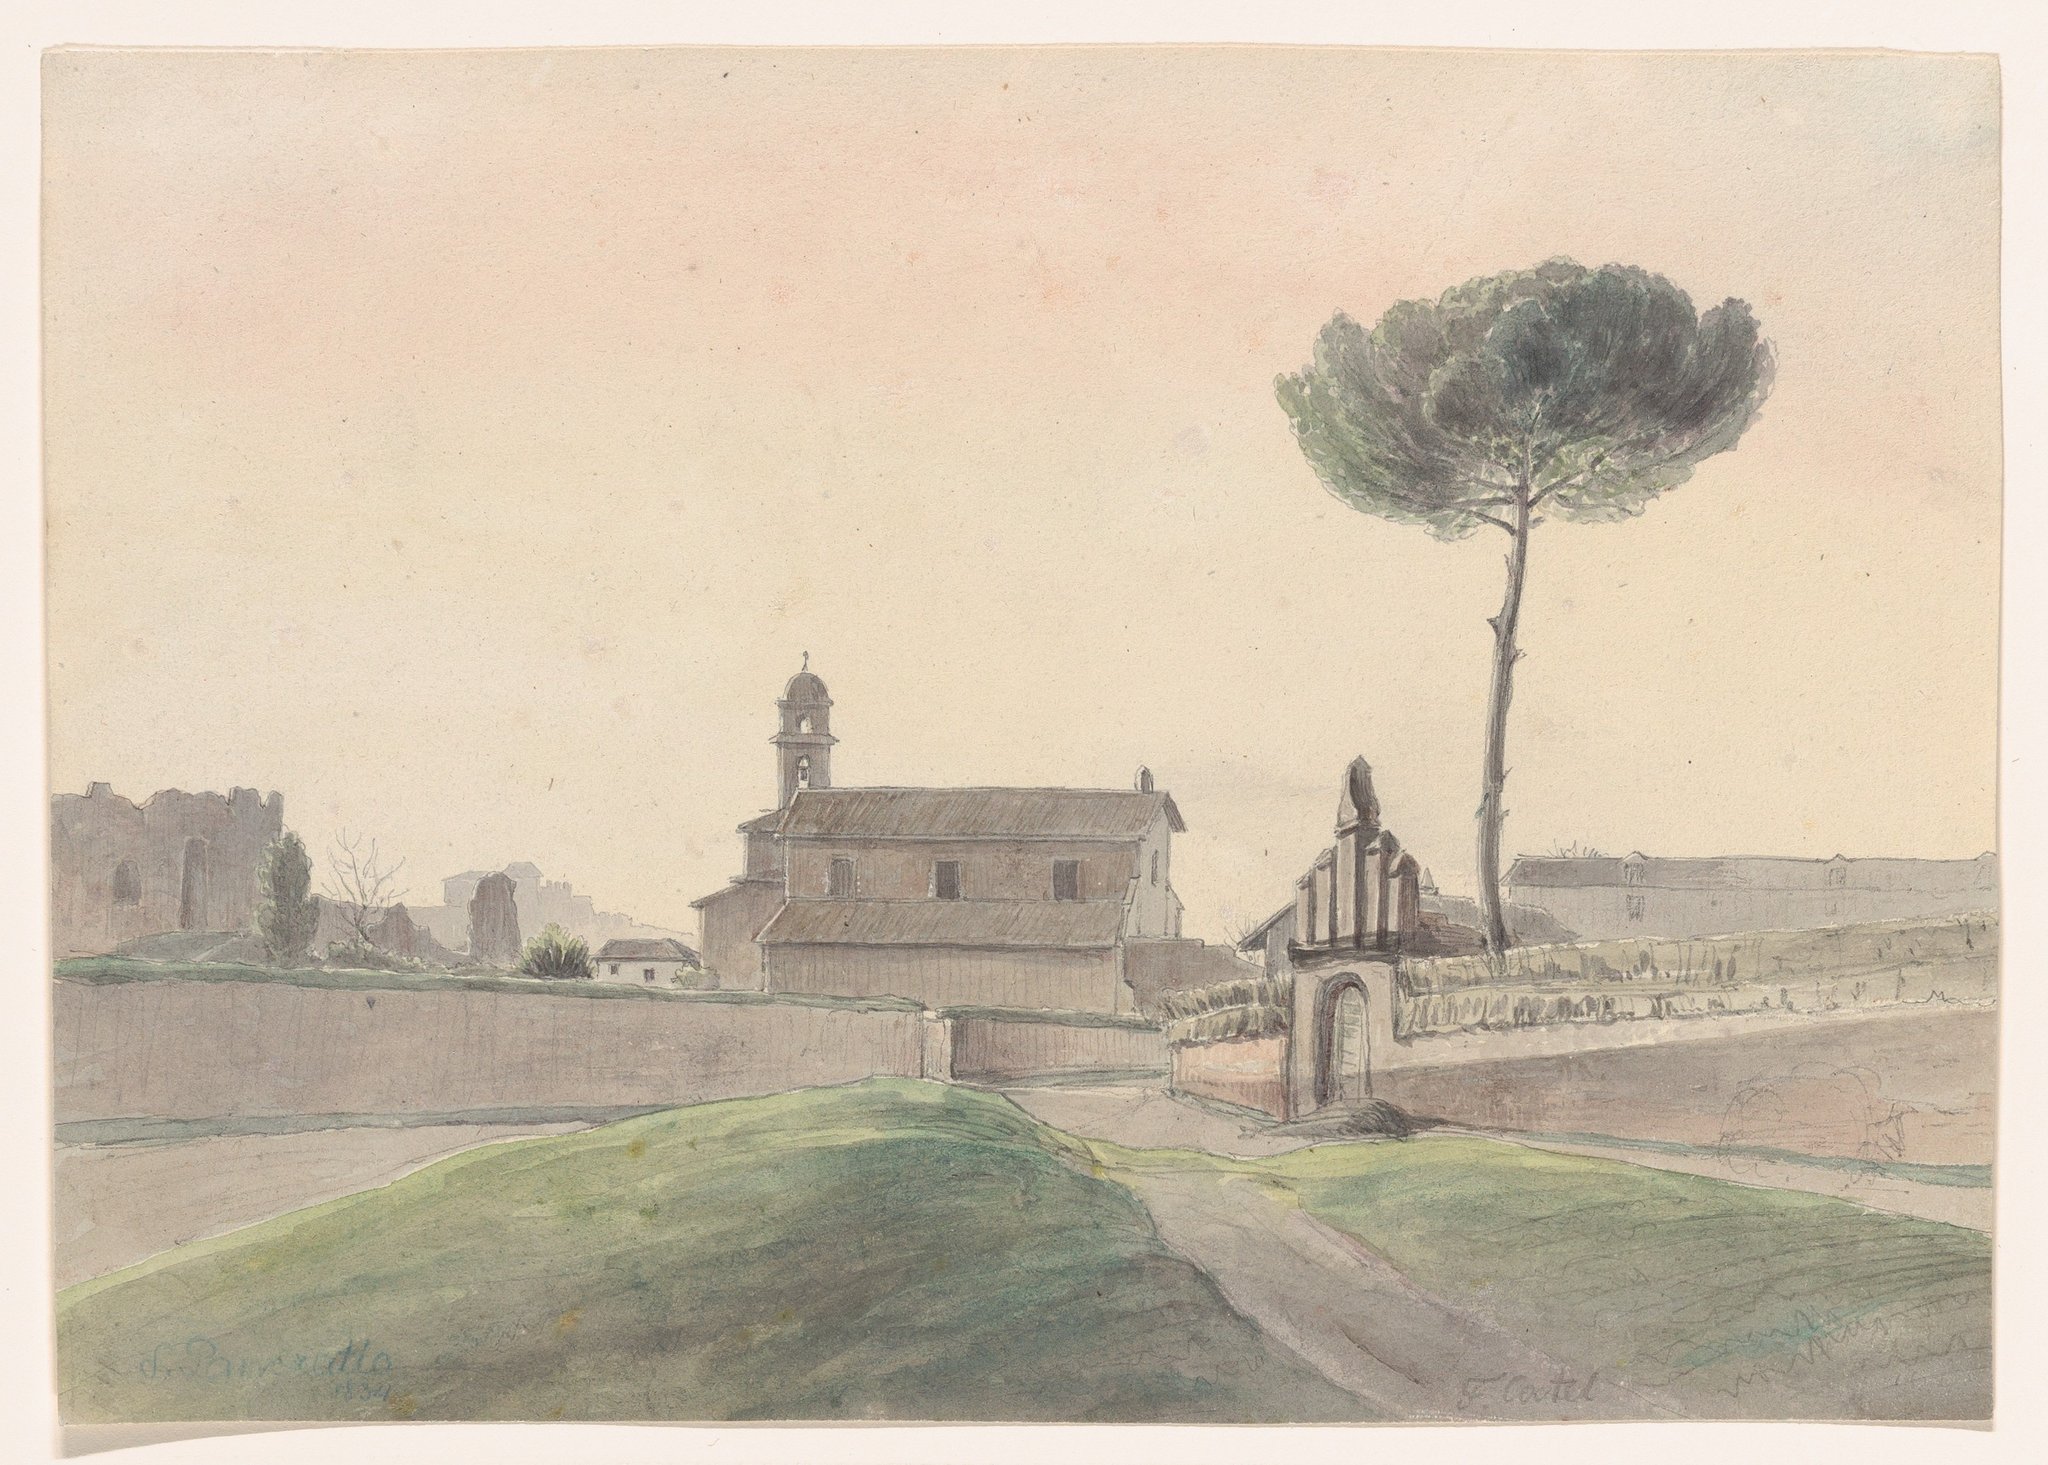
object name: drawing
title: View of the Church of San Pancrazio, Rome, from the South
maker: franz ludwig catel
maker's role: artist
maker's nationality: german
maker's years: 1778-1856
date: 1834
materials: graphite, watercolor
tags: churches